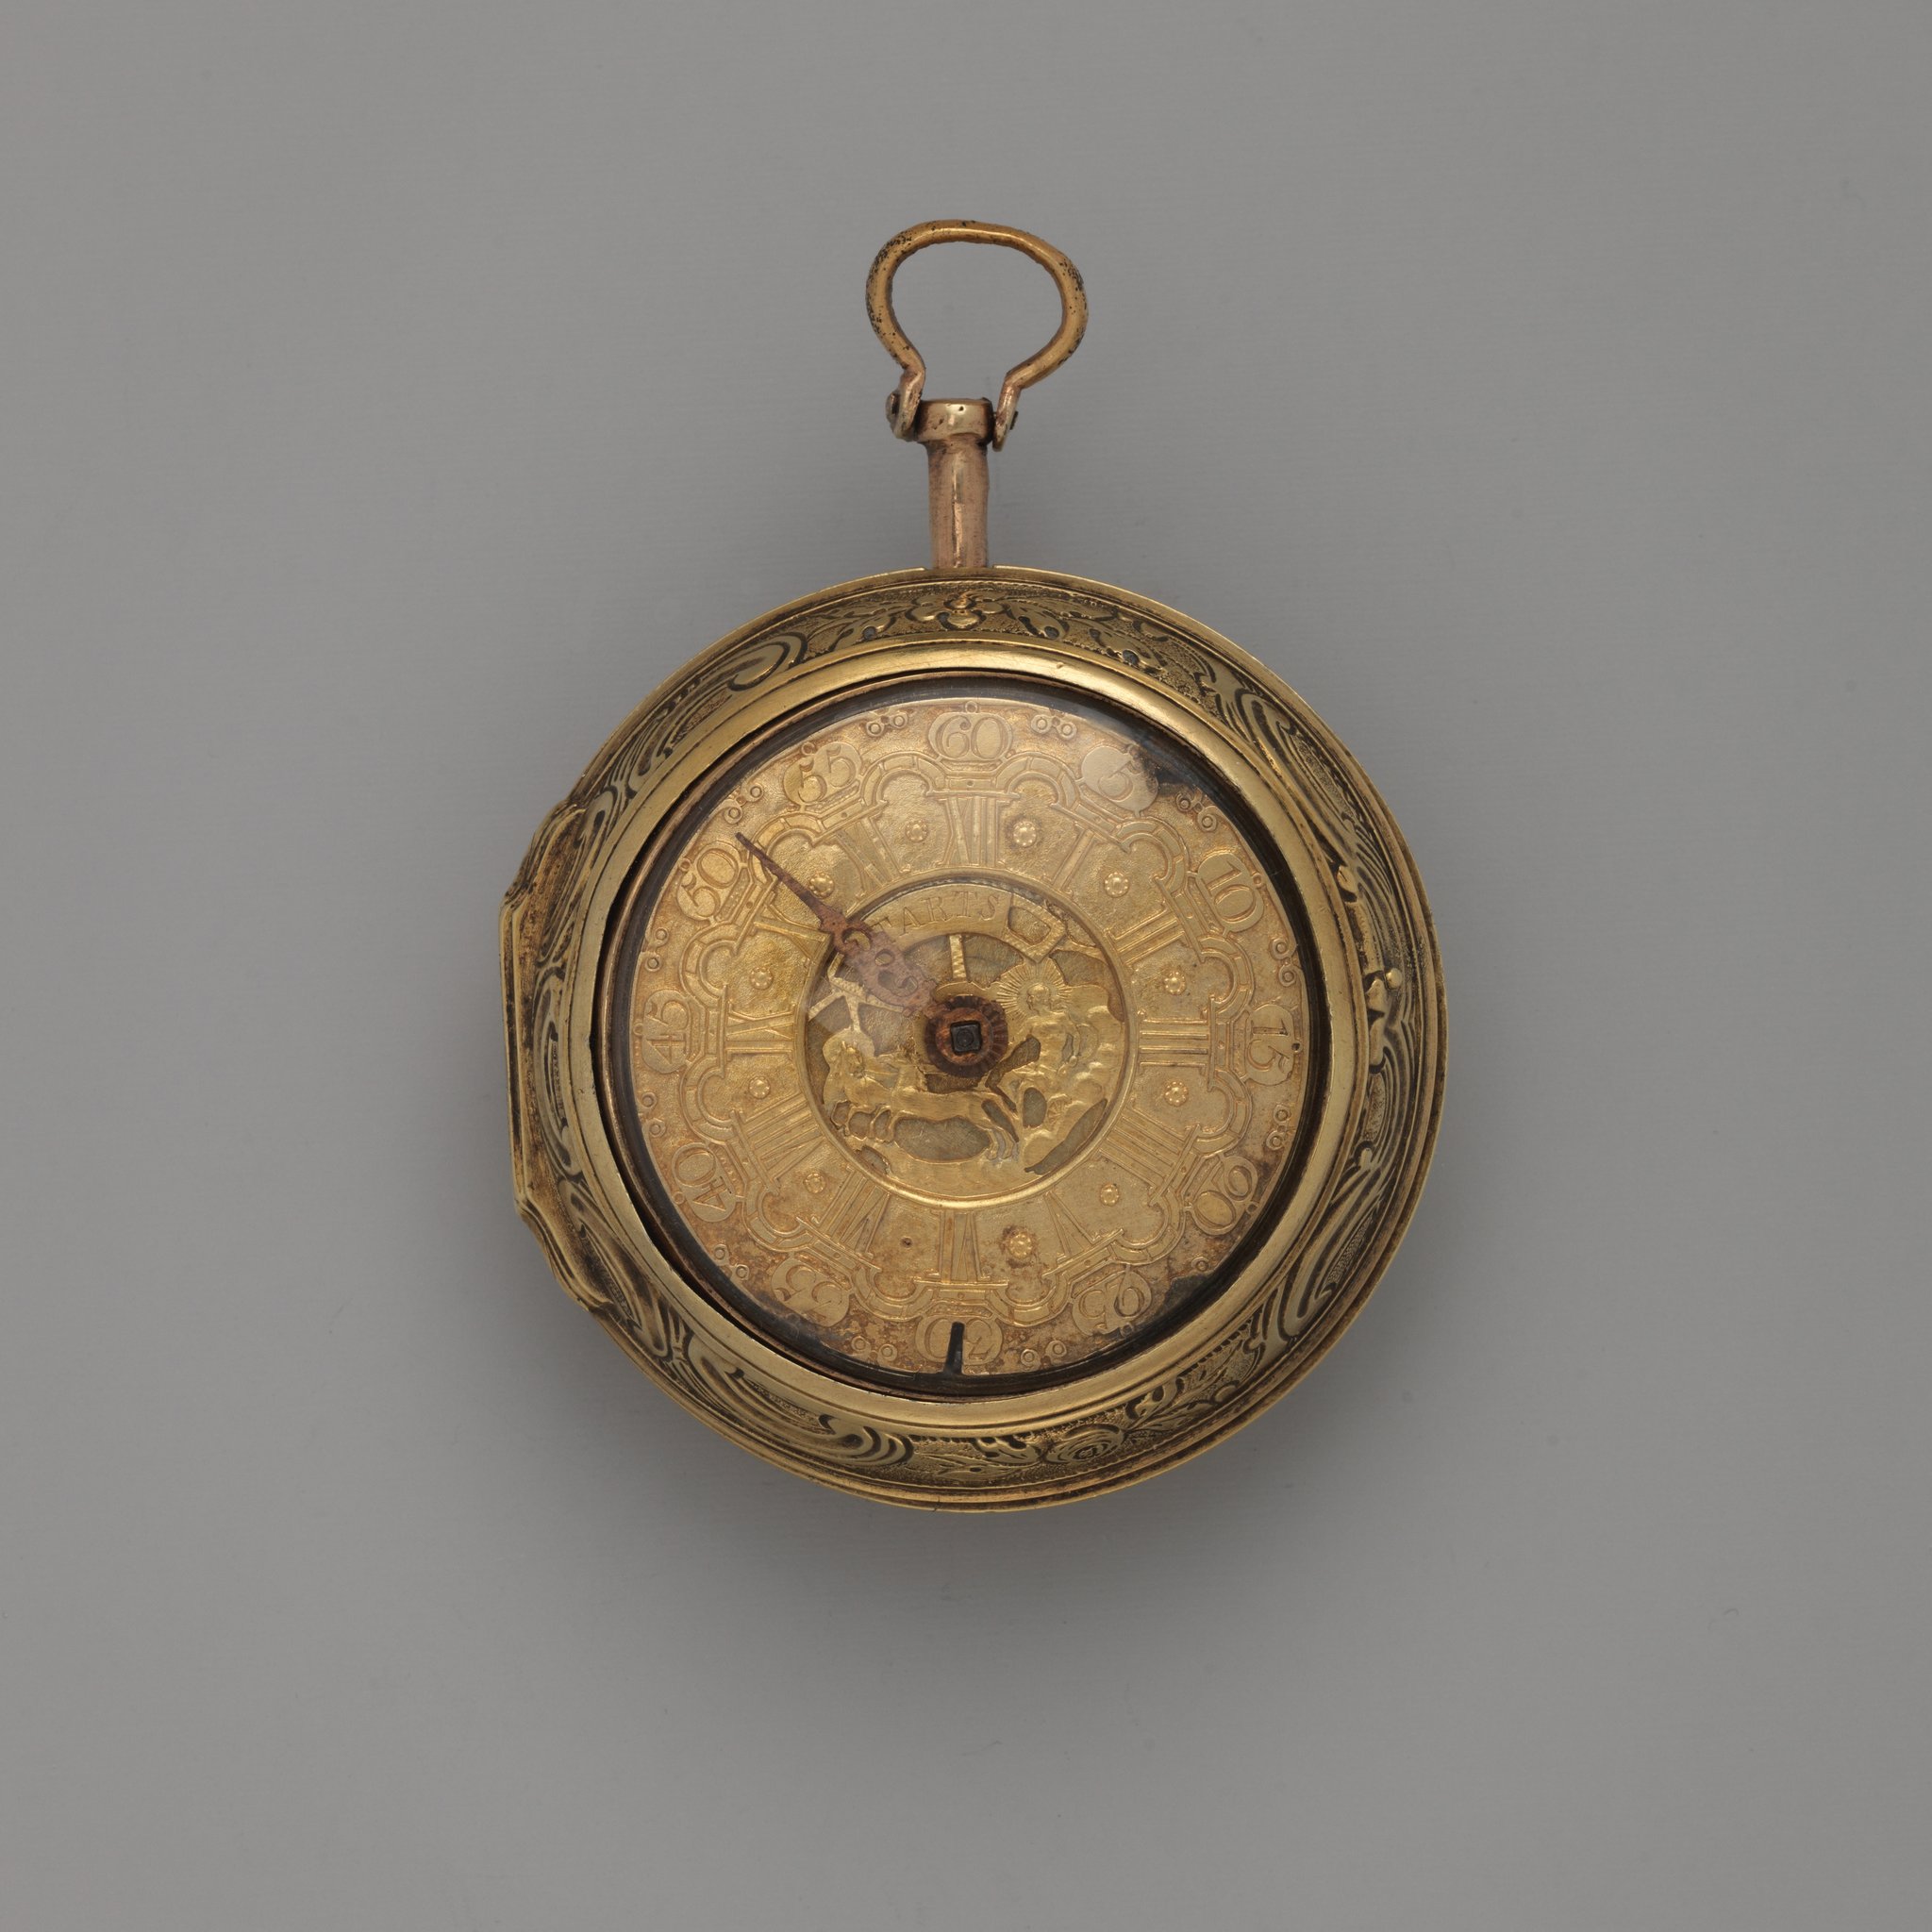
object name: watch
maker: j. tarts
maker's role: maker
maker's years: 1755-1790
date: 1701-1800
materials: brass, gold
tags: men,horses